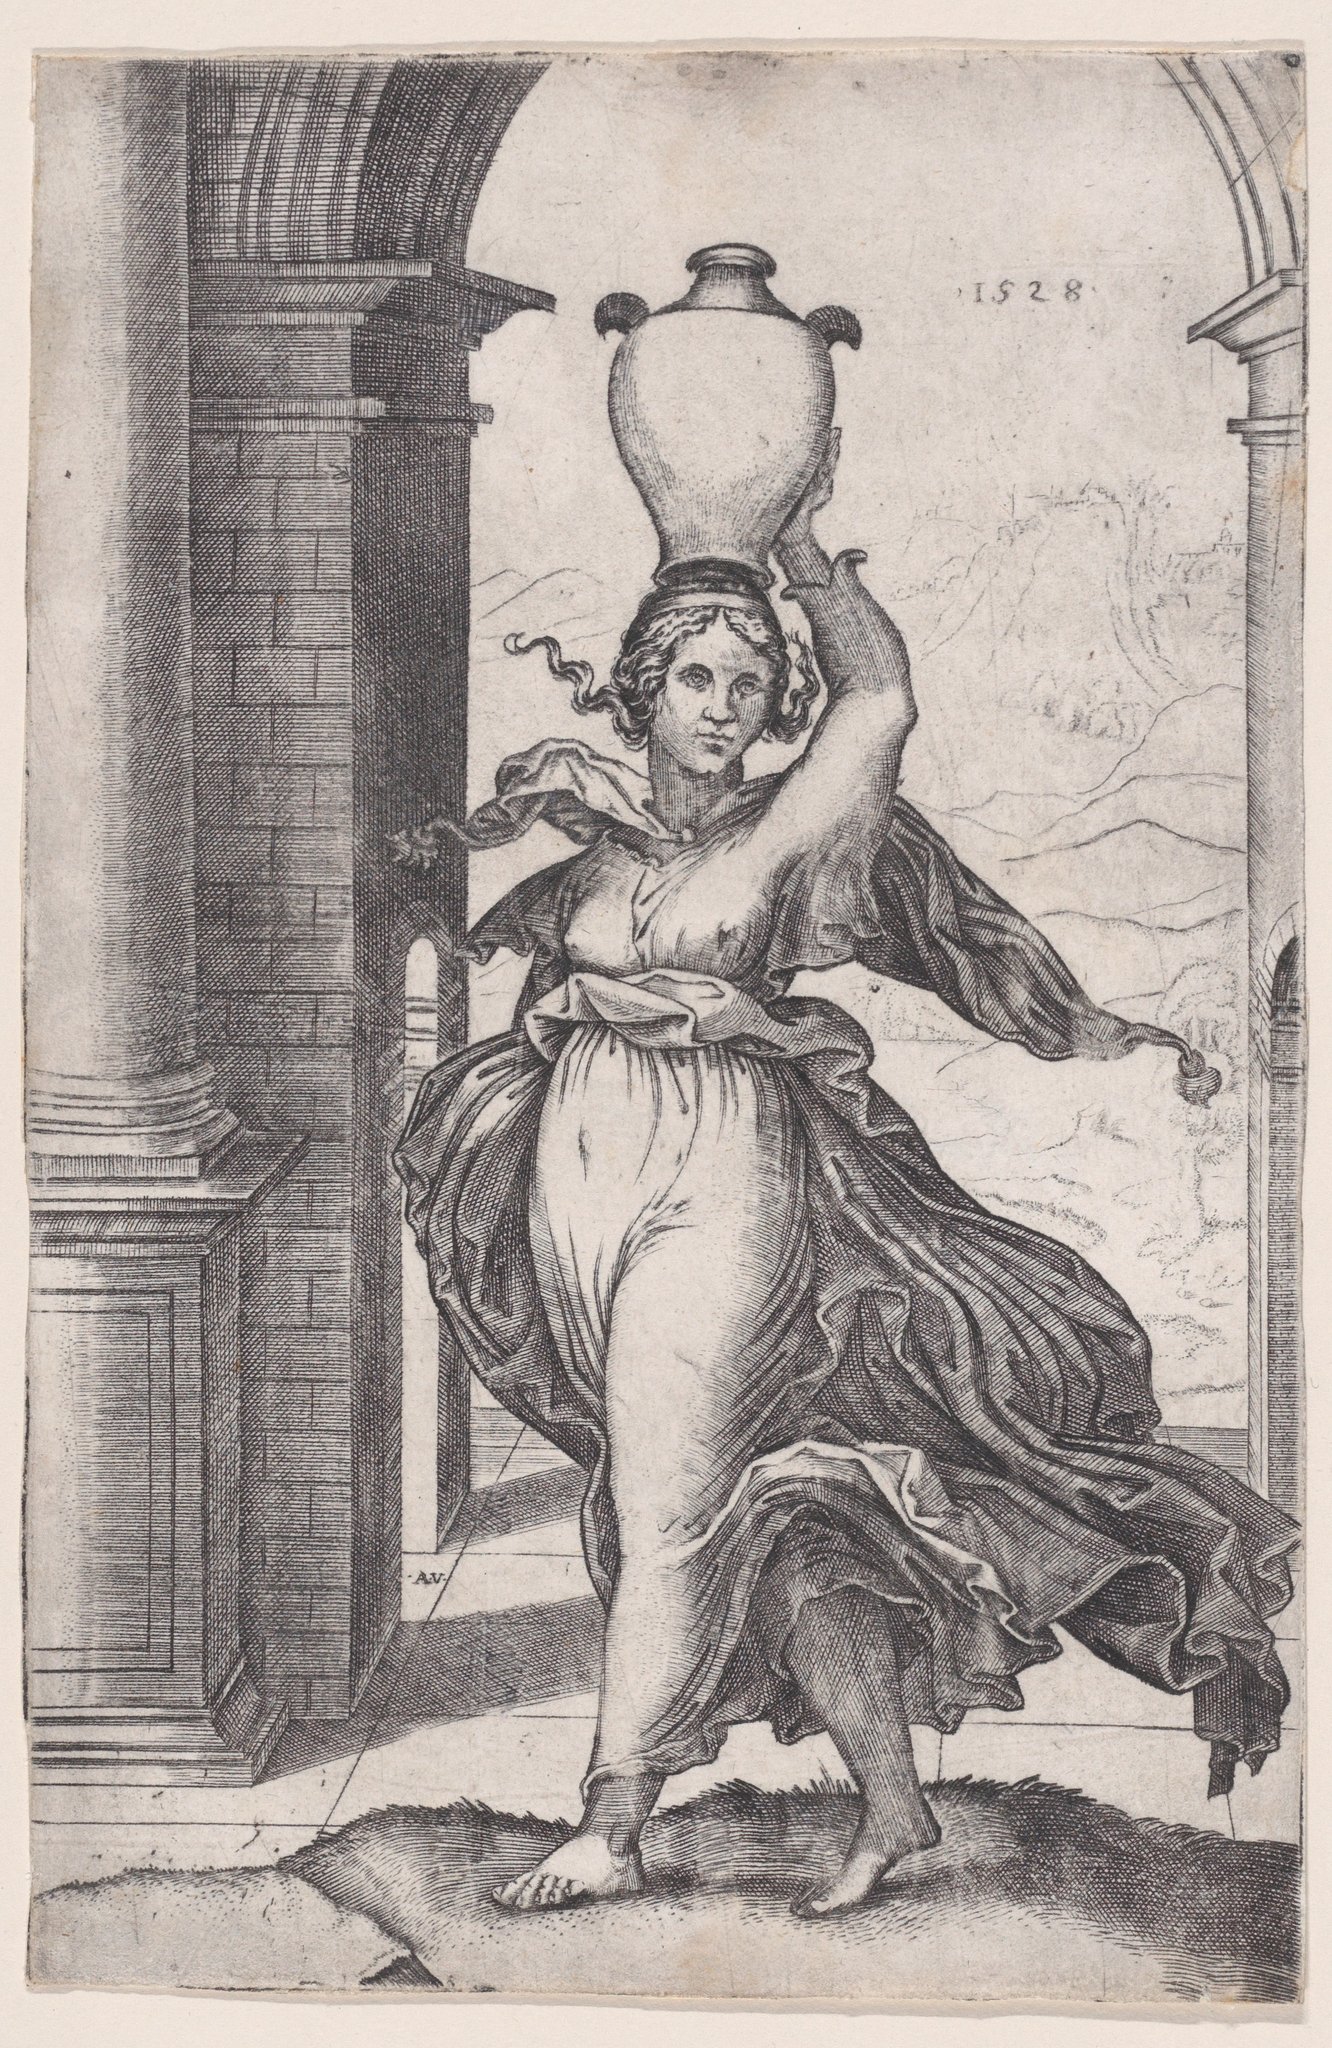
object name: print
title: Woman Carring a Vase on Her Head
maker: agostino veneziano (agostino dei musi)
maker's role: artist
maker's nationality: italian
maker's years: 1490-1536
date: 1528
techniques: engraving